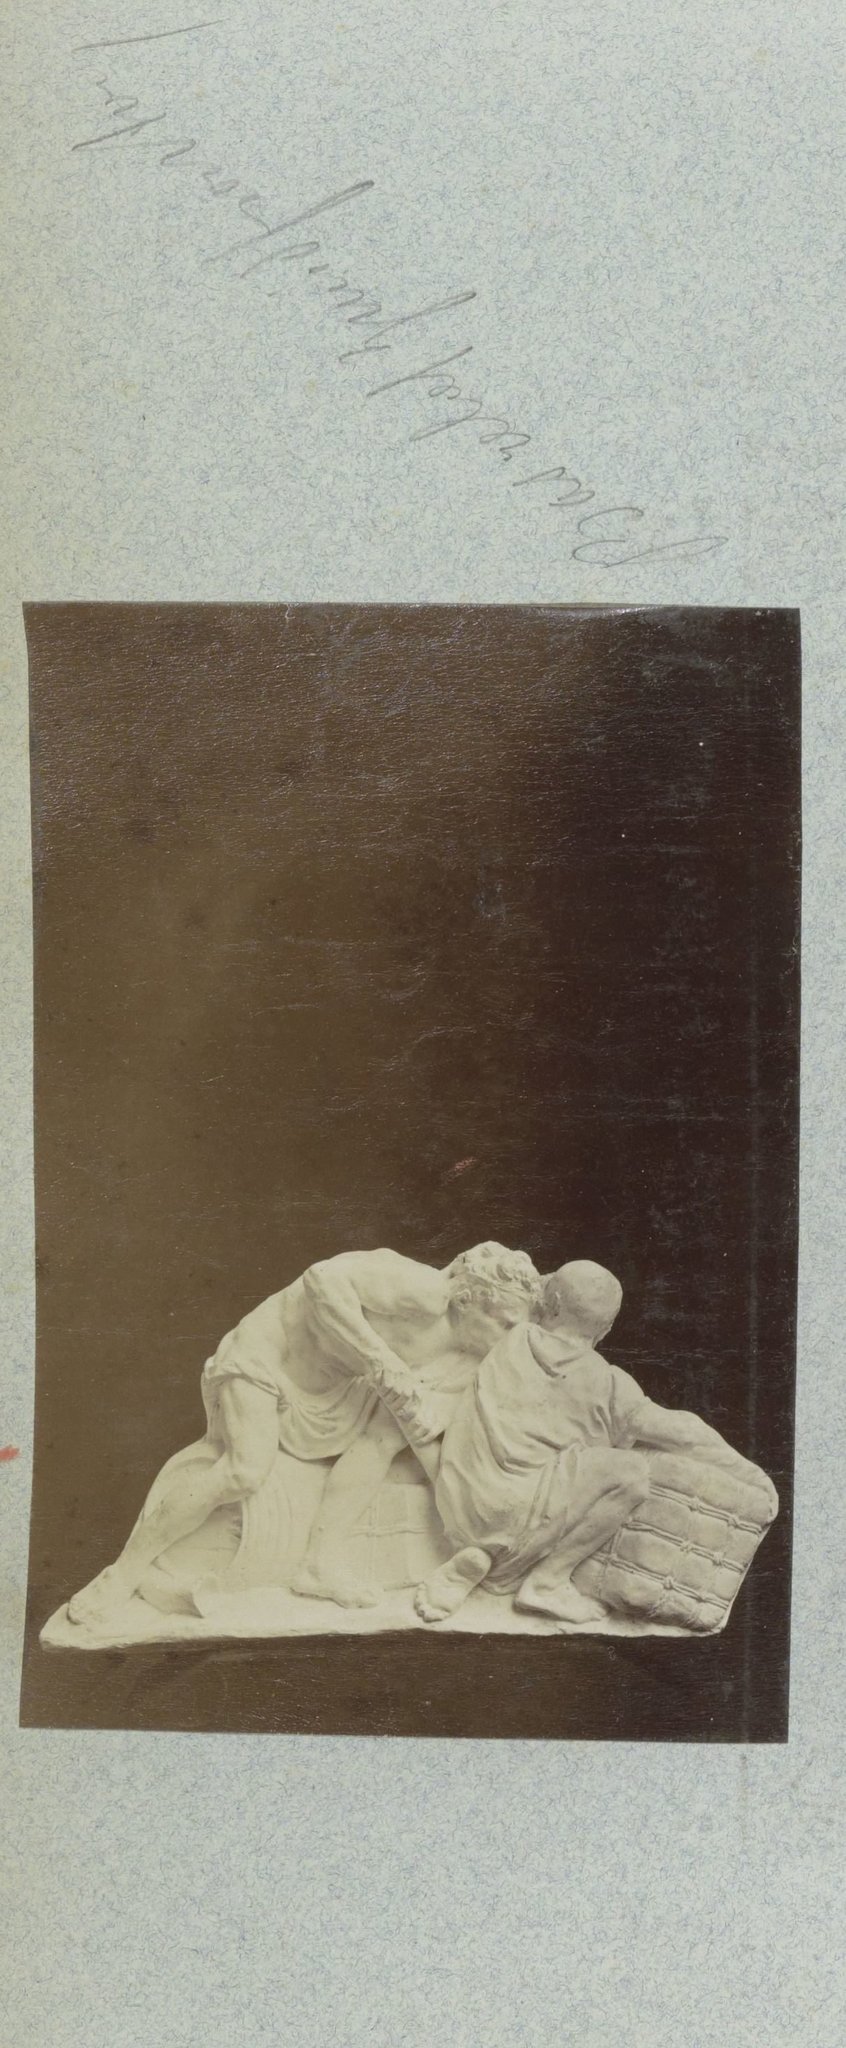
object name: album leaf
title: Gipsen afgietsel van een bas-reliëf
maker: Anonymous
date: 1875-1900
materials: paper, photographic support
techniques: albumen print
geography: amsterdam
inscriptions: annotation: ‘Bas-reliëf [.....]’